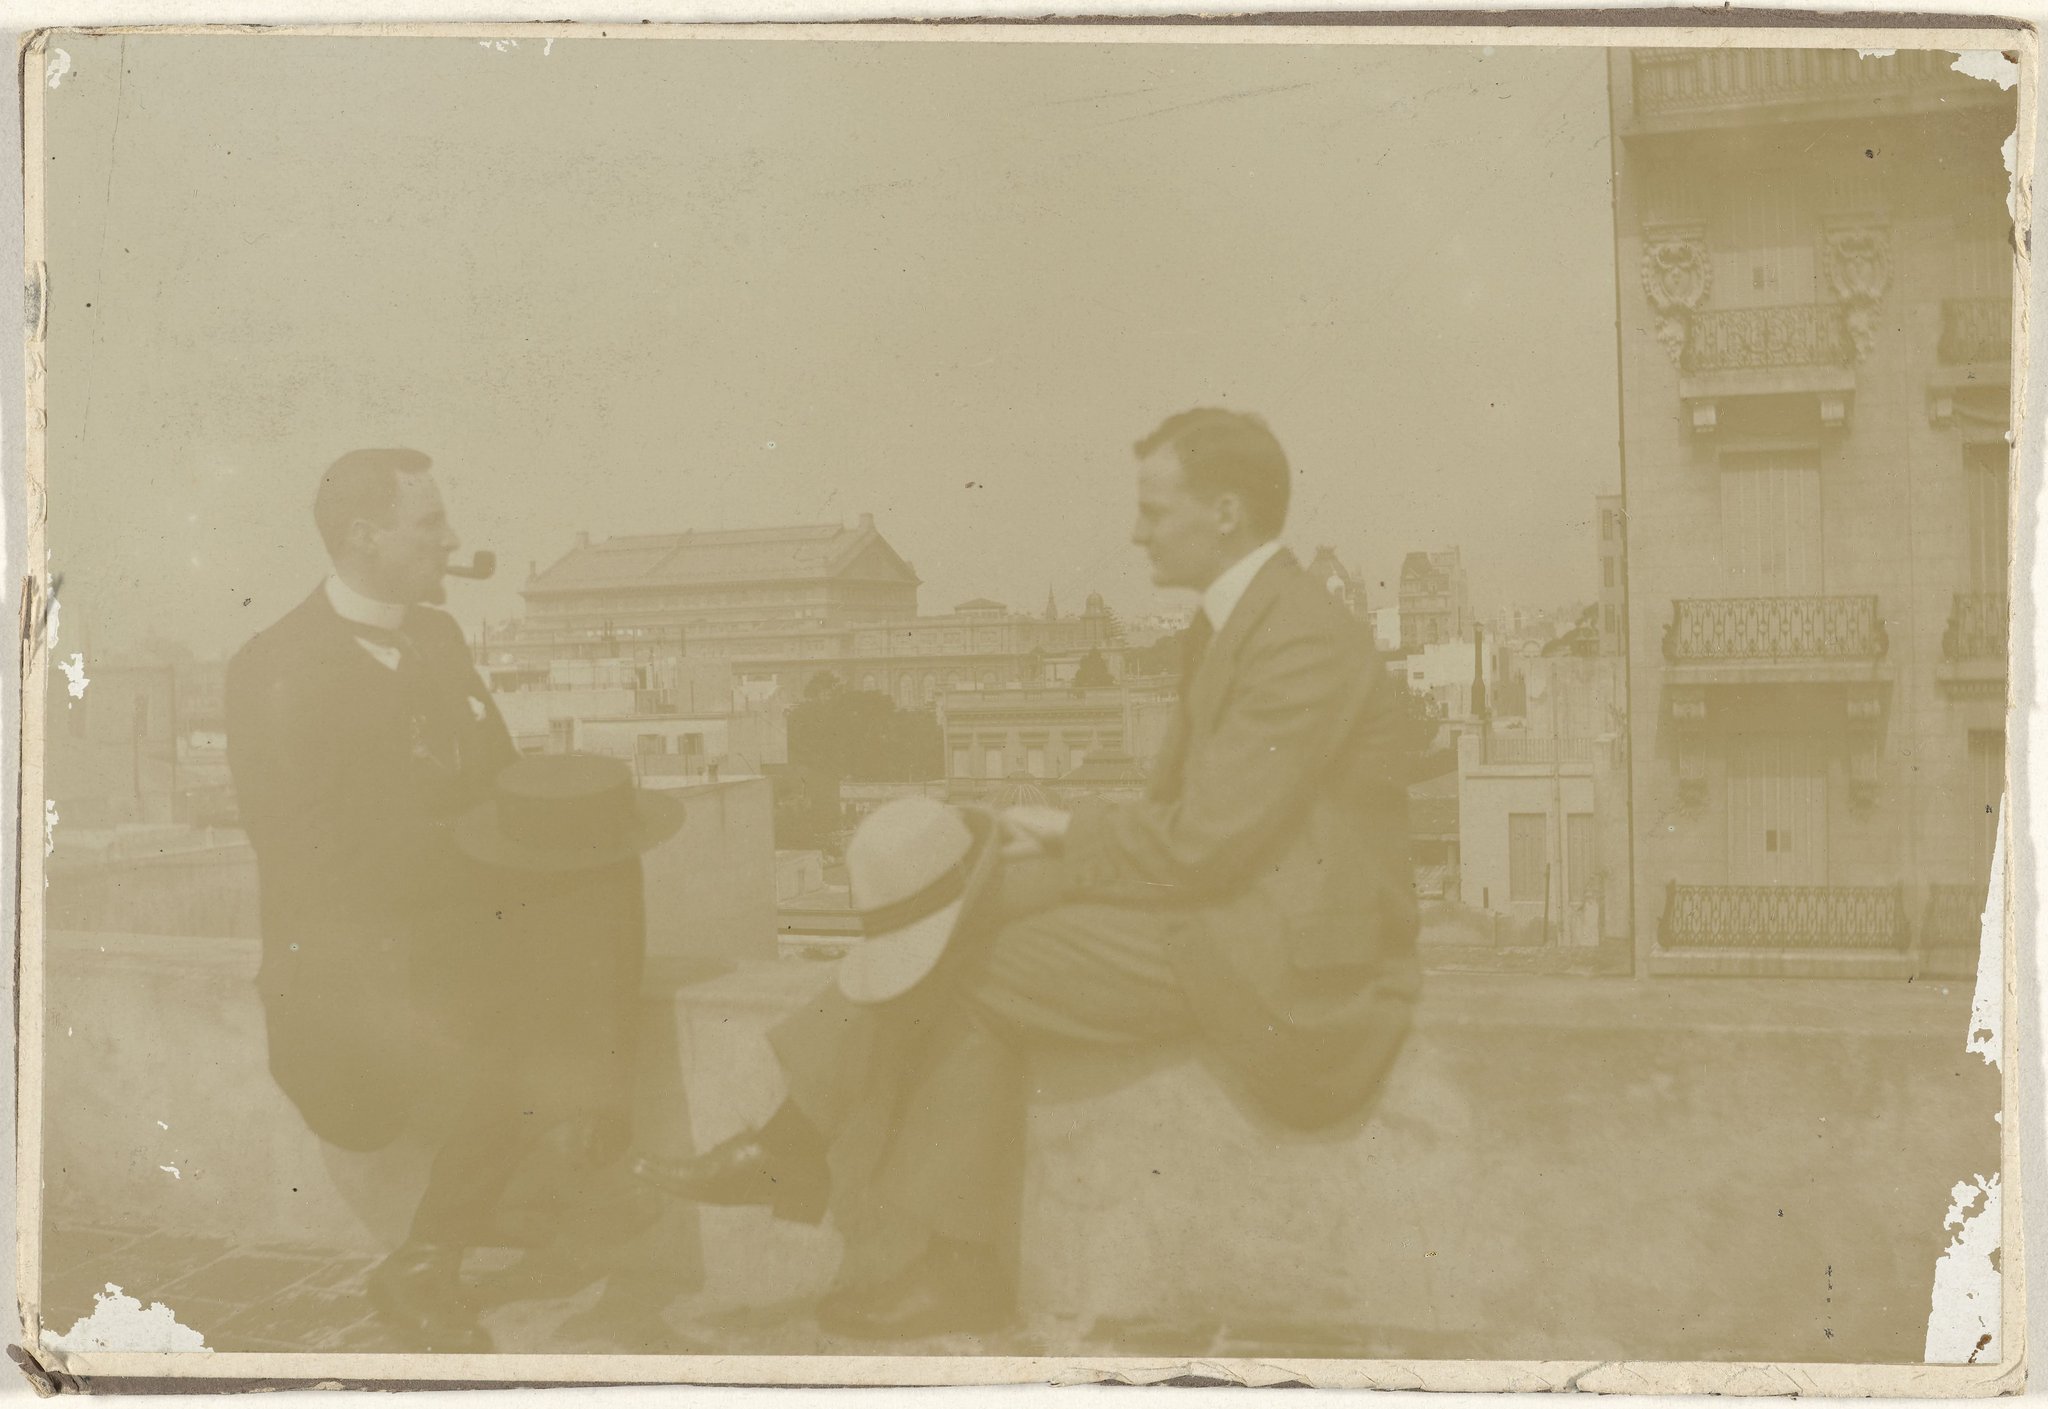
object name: photograph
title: Portret van Bram en David Vermeulen tegen de achtergrond van een stad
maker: Anonymous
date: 1880-1920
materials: cardboard, photographic support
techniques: collodion silver print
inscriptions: name: ‘Bram en David’